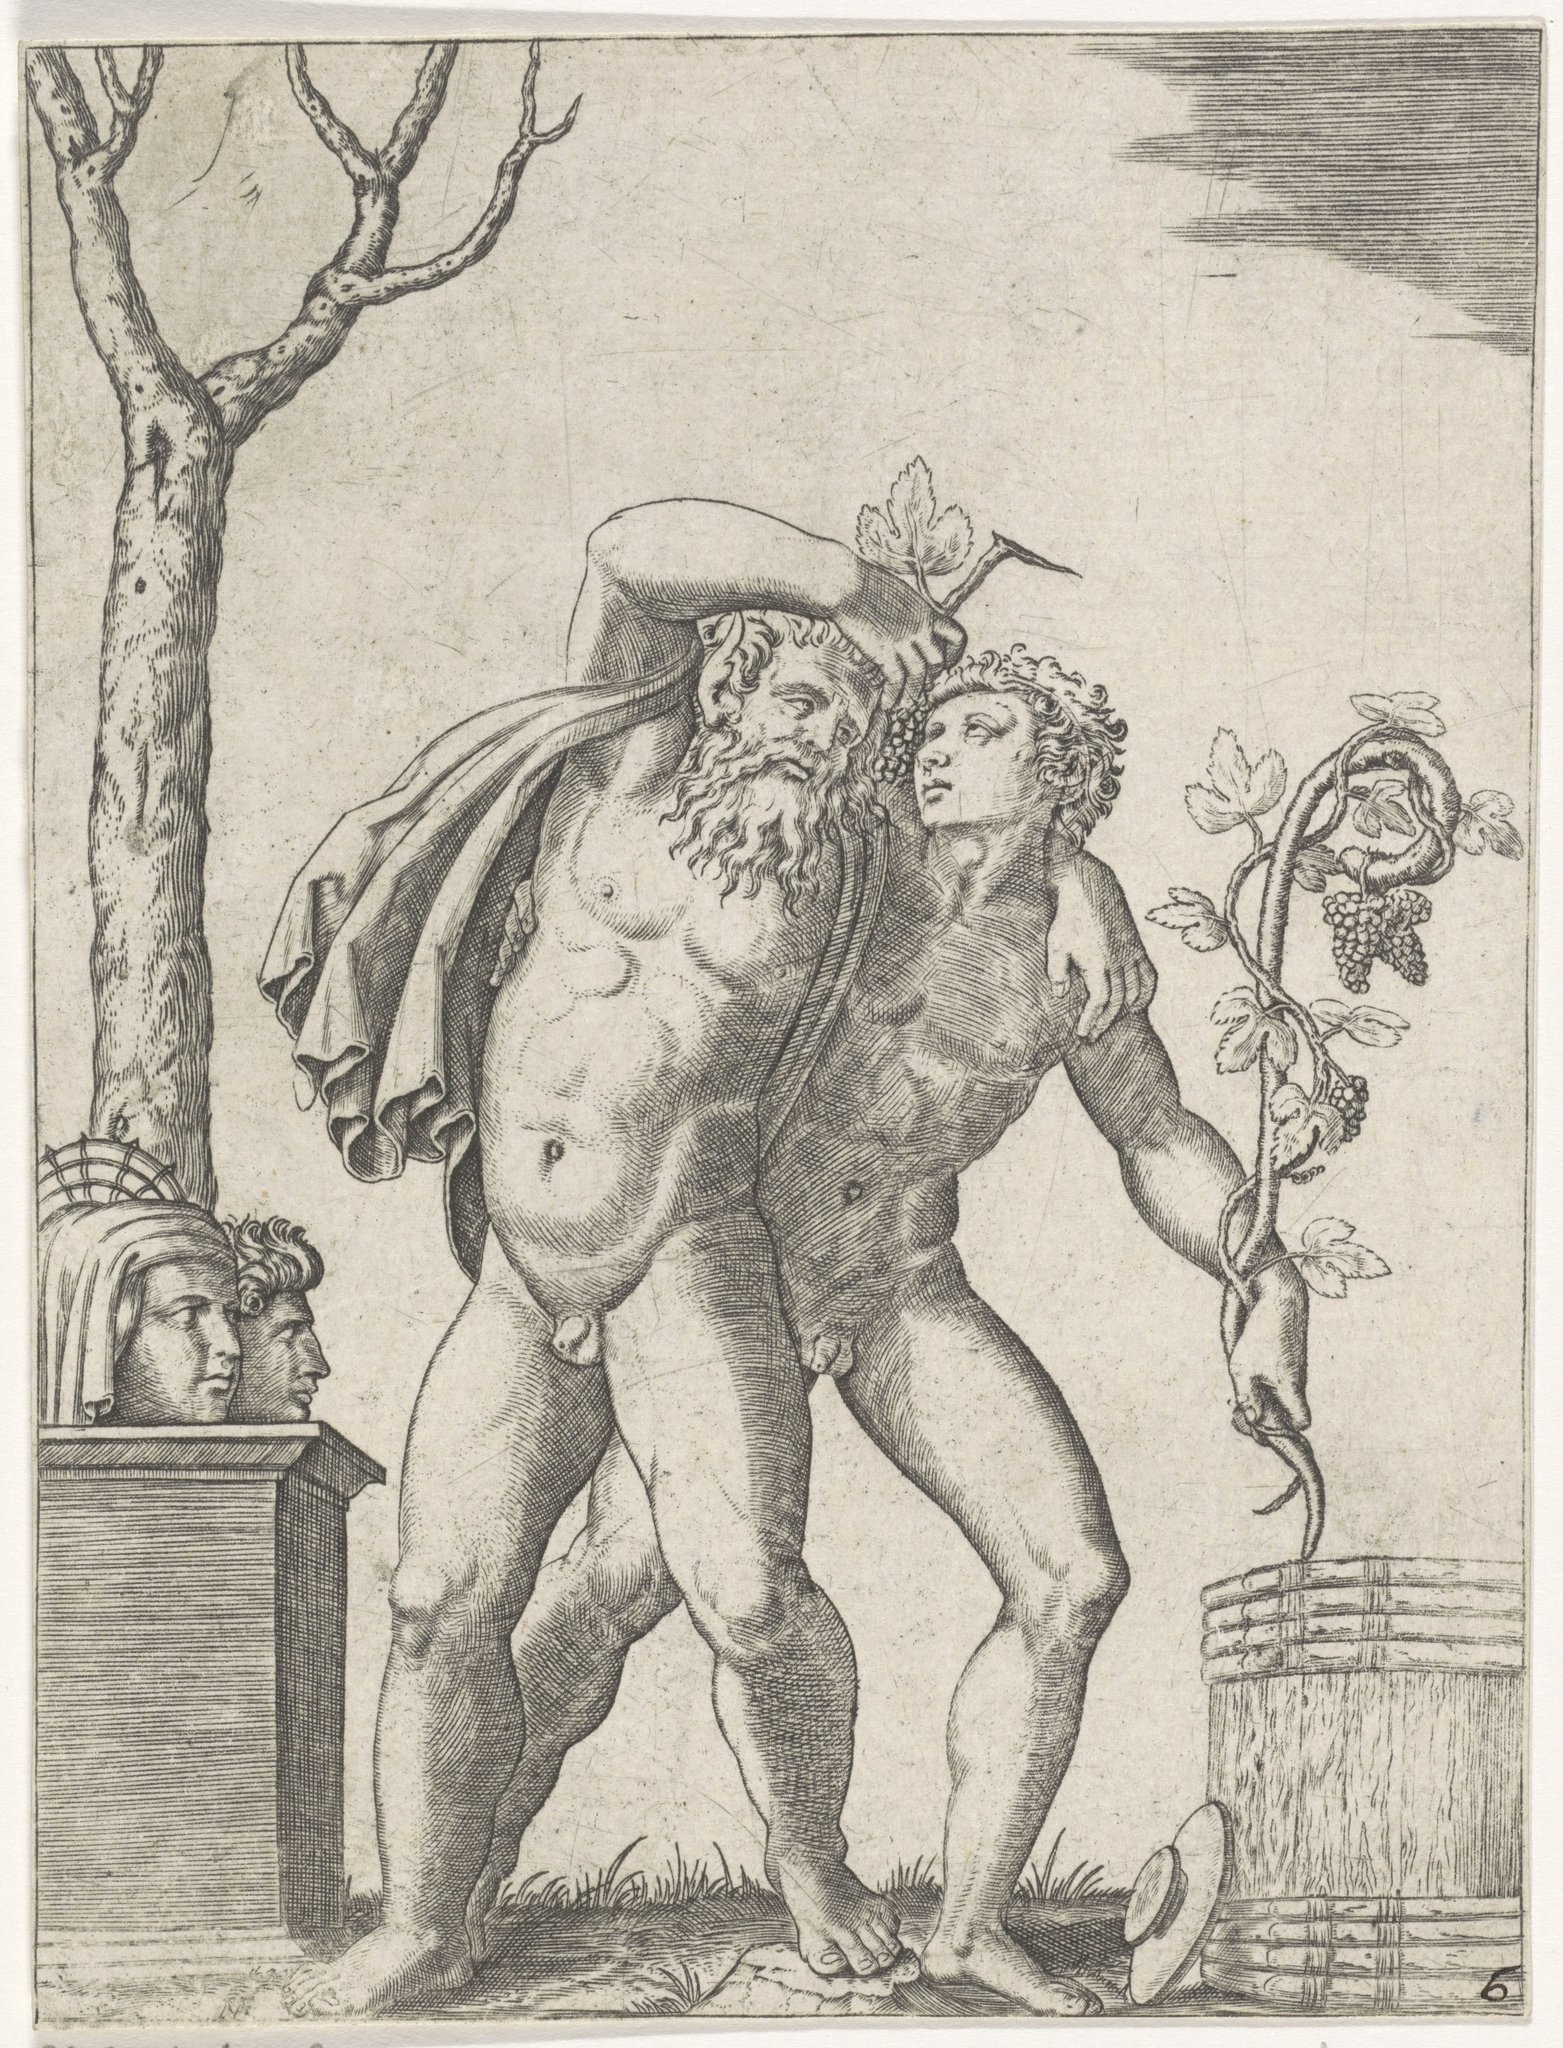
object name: print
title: Silenus ondersteund door een jonge bacchant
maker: marcantonio raimondi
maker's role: print maker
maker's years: 1470-1534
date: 1520-1525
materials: paper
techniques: engraving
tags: male bacchant(es), (story of) silenus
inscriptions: collector's mark: Lugt 11, collector's mark: Lugt 10, number: ‘5’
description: Compositie mogelijk gebaseerd op een ontwerp van Raphael of Giulio Romano. Ook een reliëf op een sarcofaag wordt in de literatuur als inspiratiebron genoemd.